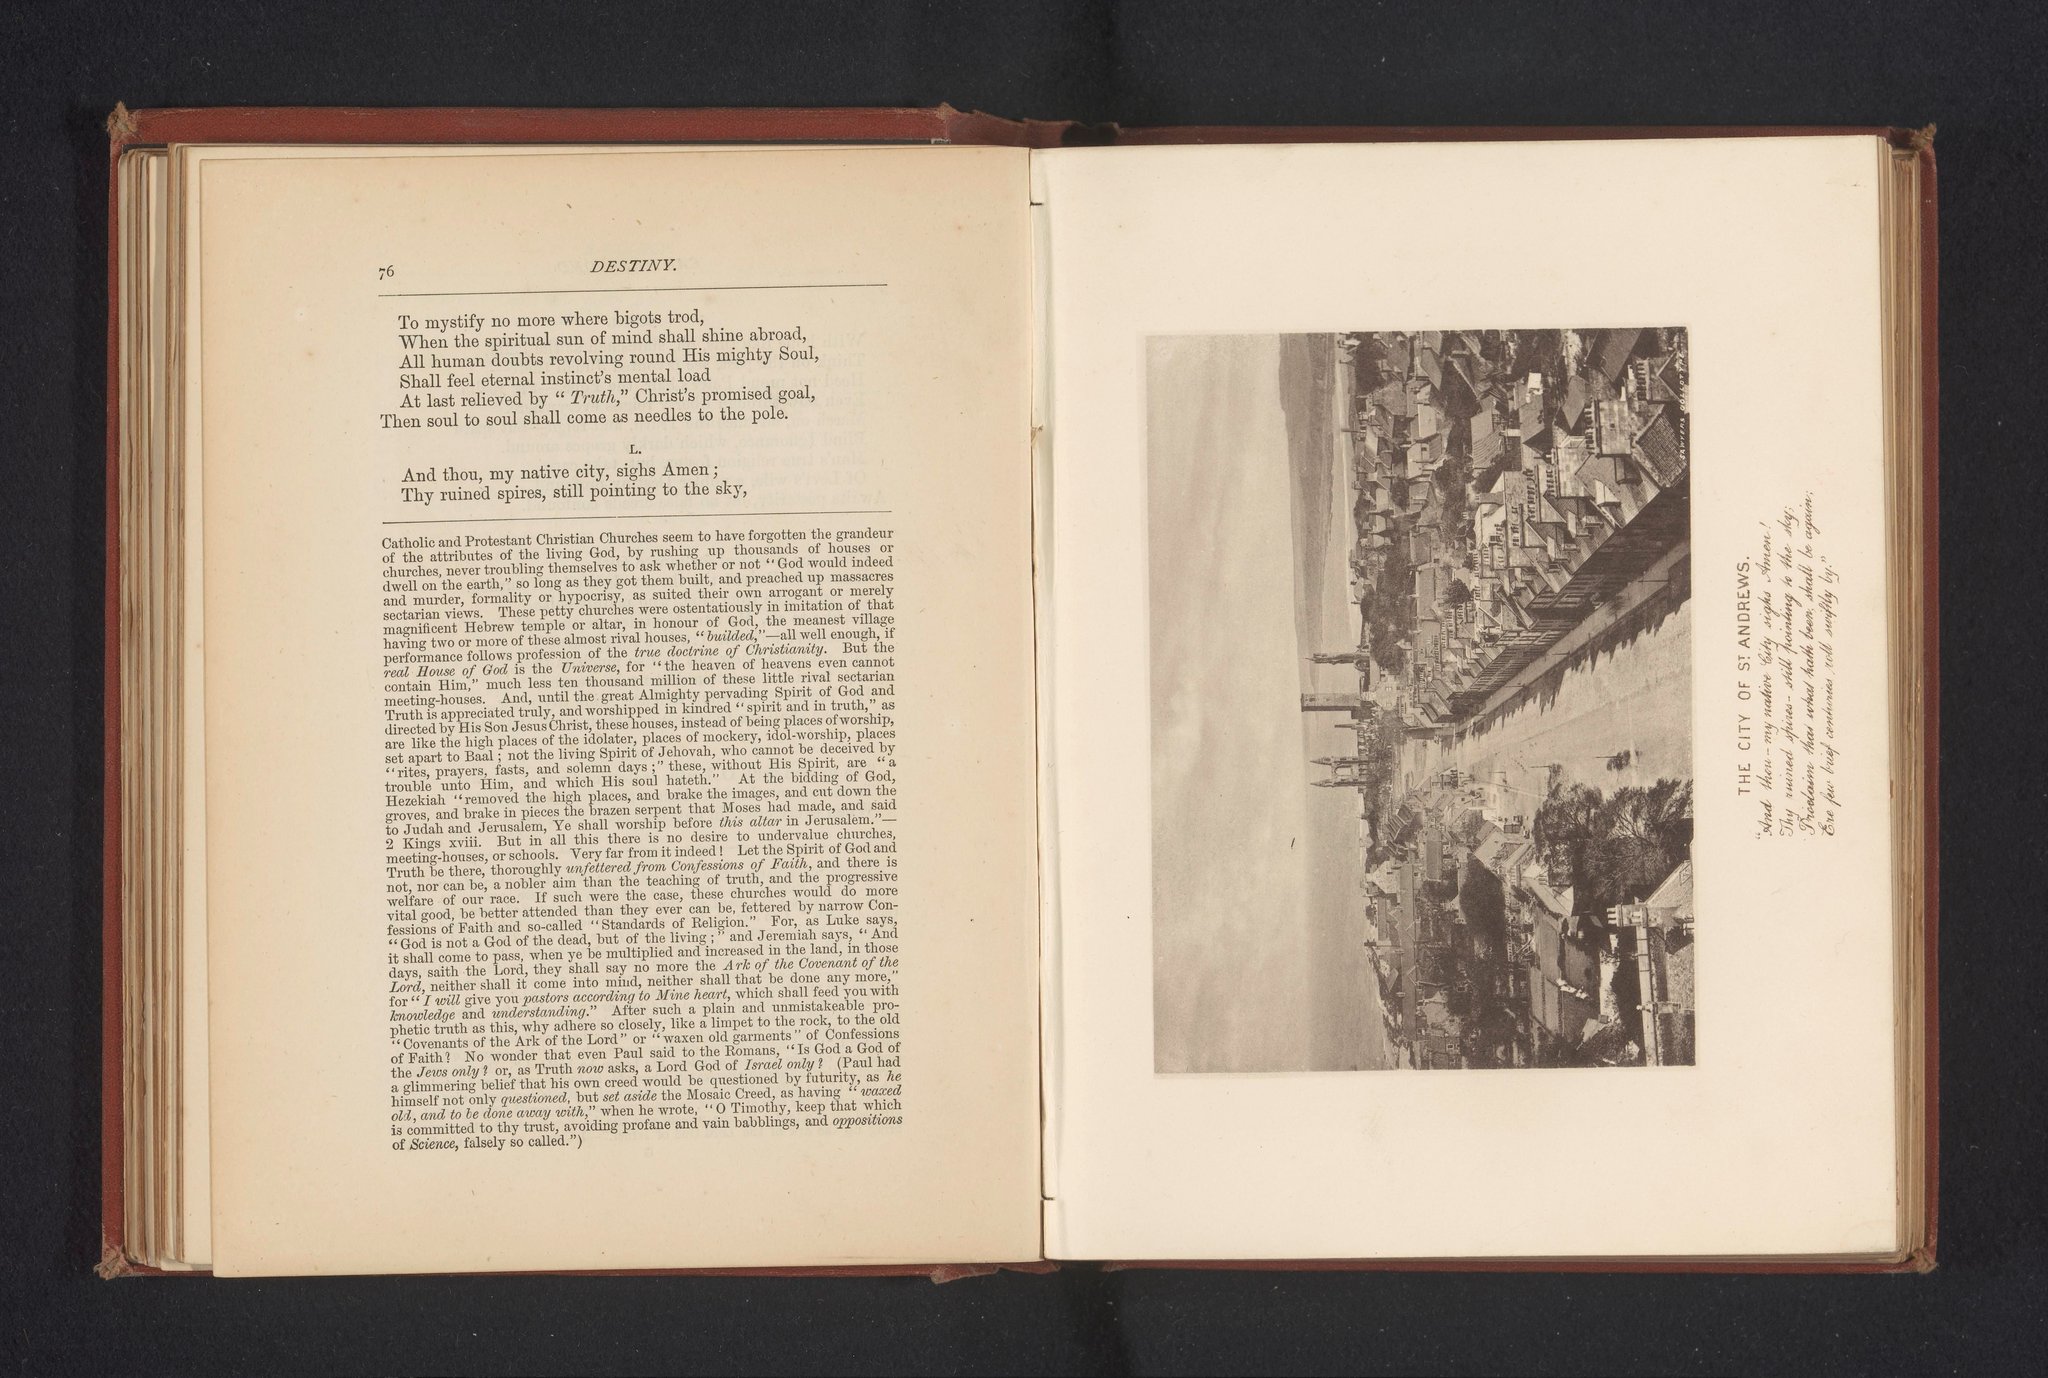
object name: page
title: The city of St. Andrews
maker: thomas rodger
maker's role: fotograaf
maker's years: 1833-1883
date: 1866-1876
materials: paper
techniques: photograph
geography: saint andrews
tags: city-view, and landscape with man-made constructions, ruin of church, monastery, etc.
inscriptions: inscription: ‘“ And thou-my native City sighs Amen! Thy ruined spires - still pointing to the sky; Proclaim that what hath been, shall be again; Ere few brief centuries roll swiftly by.”’